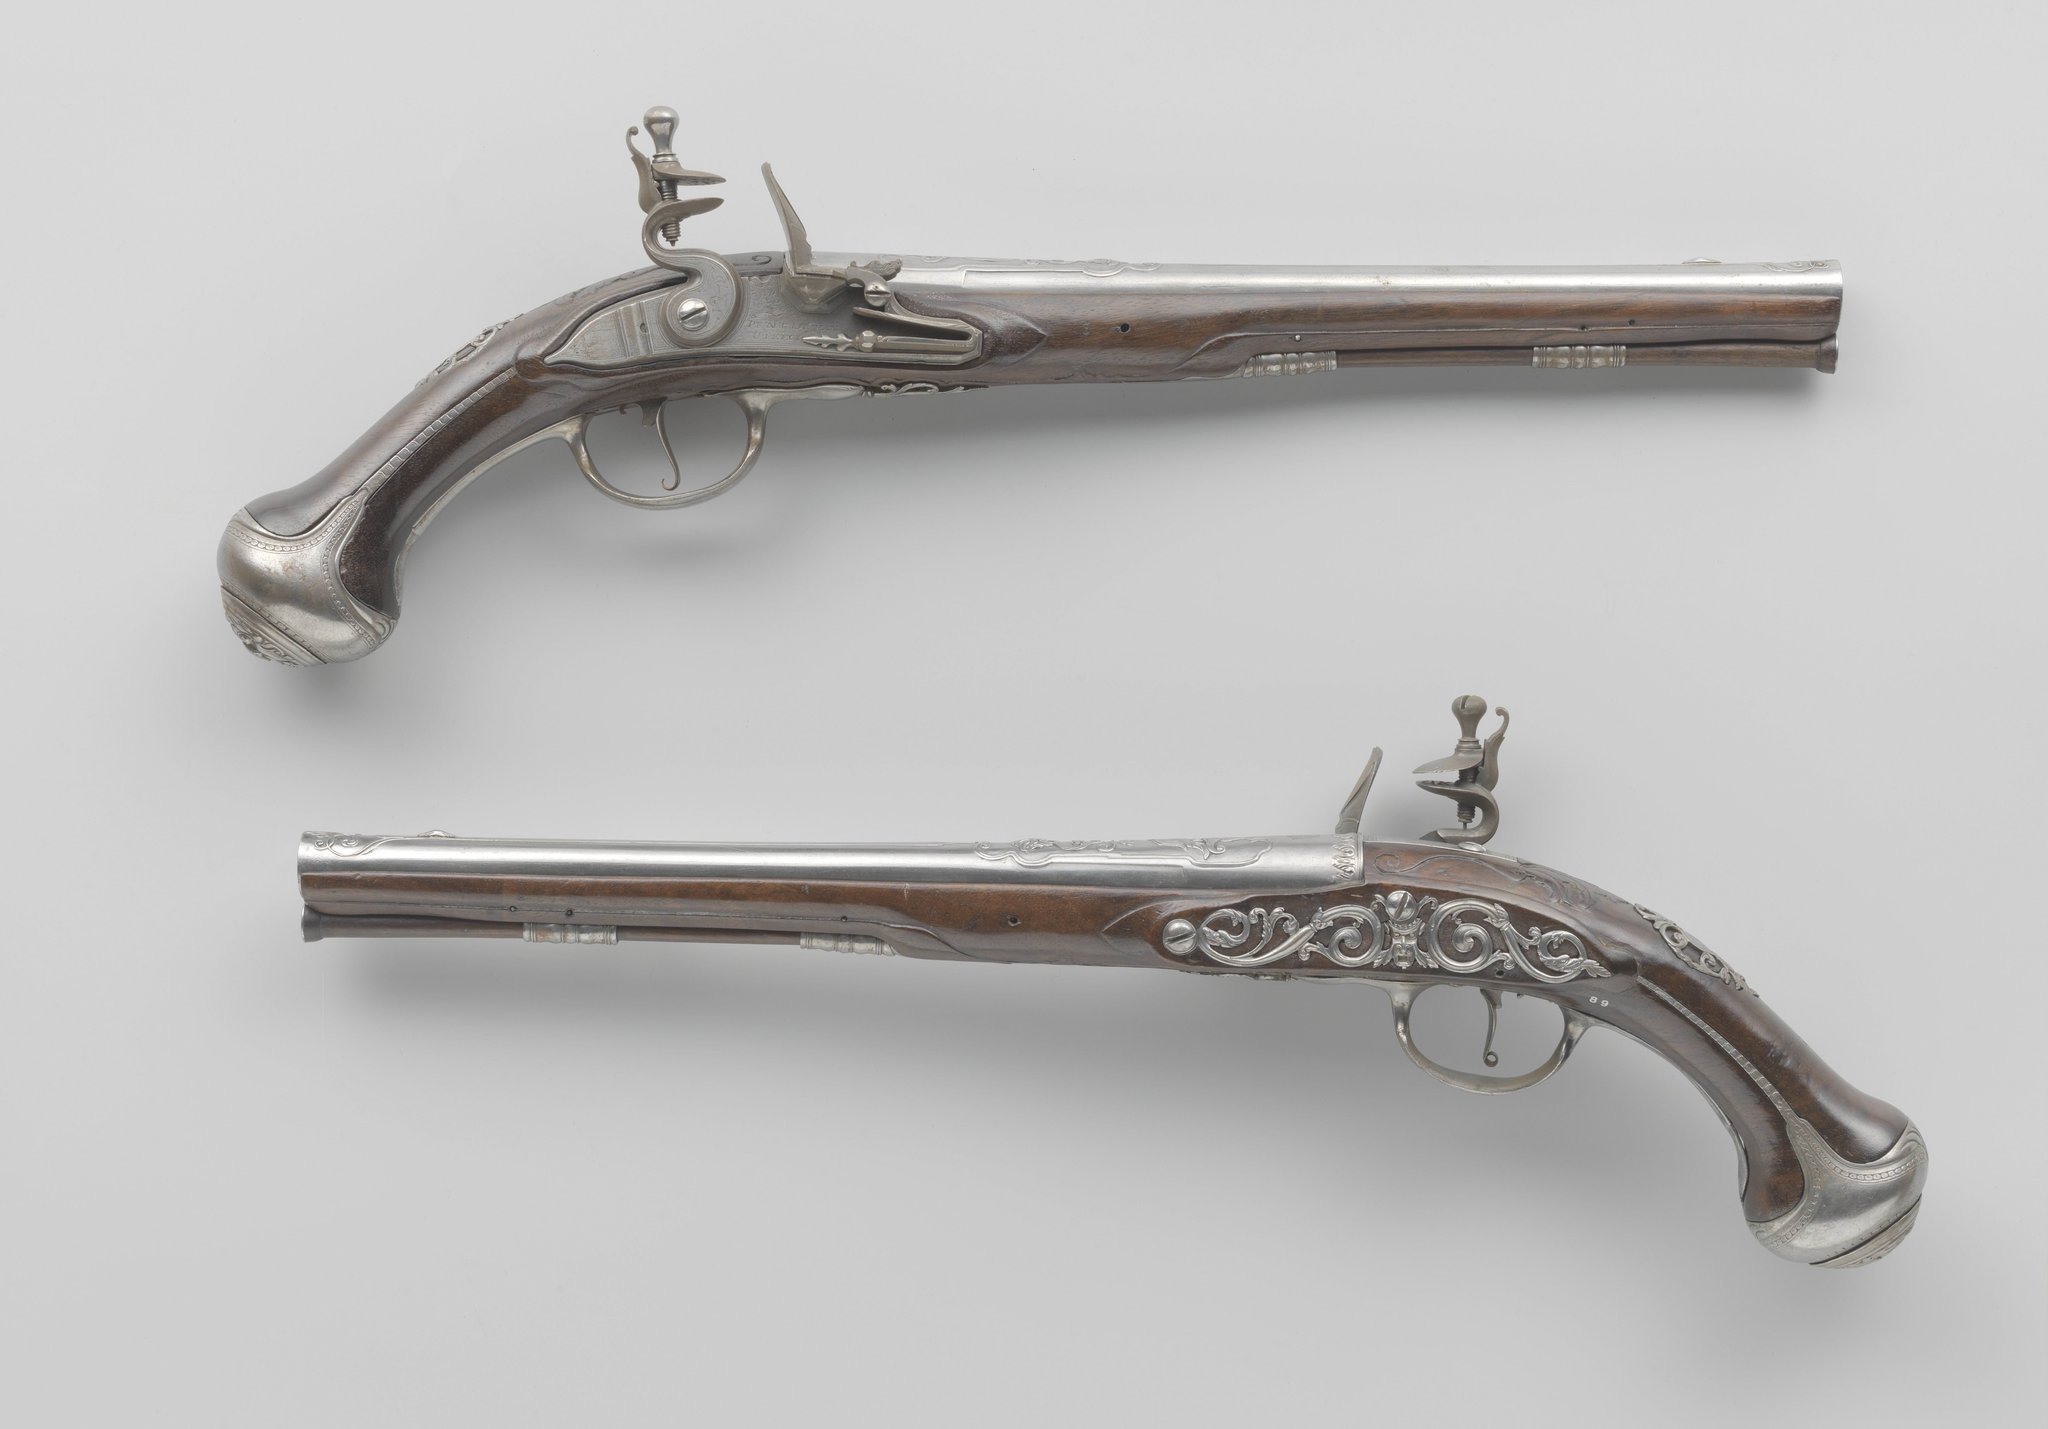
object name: flintlock pistol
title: Vuursteenpistool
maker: barend penterman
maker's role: geweermaker, pistoolmaker, vuursteenslotmaker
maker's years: -1723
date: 1710-1715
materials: iron, wood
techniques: cutting, embroidery, engraving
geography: utrecht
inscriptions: coat of arms, inscription: ‘PENTERMAN // UTRECHT’